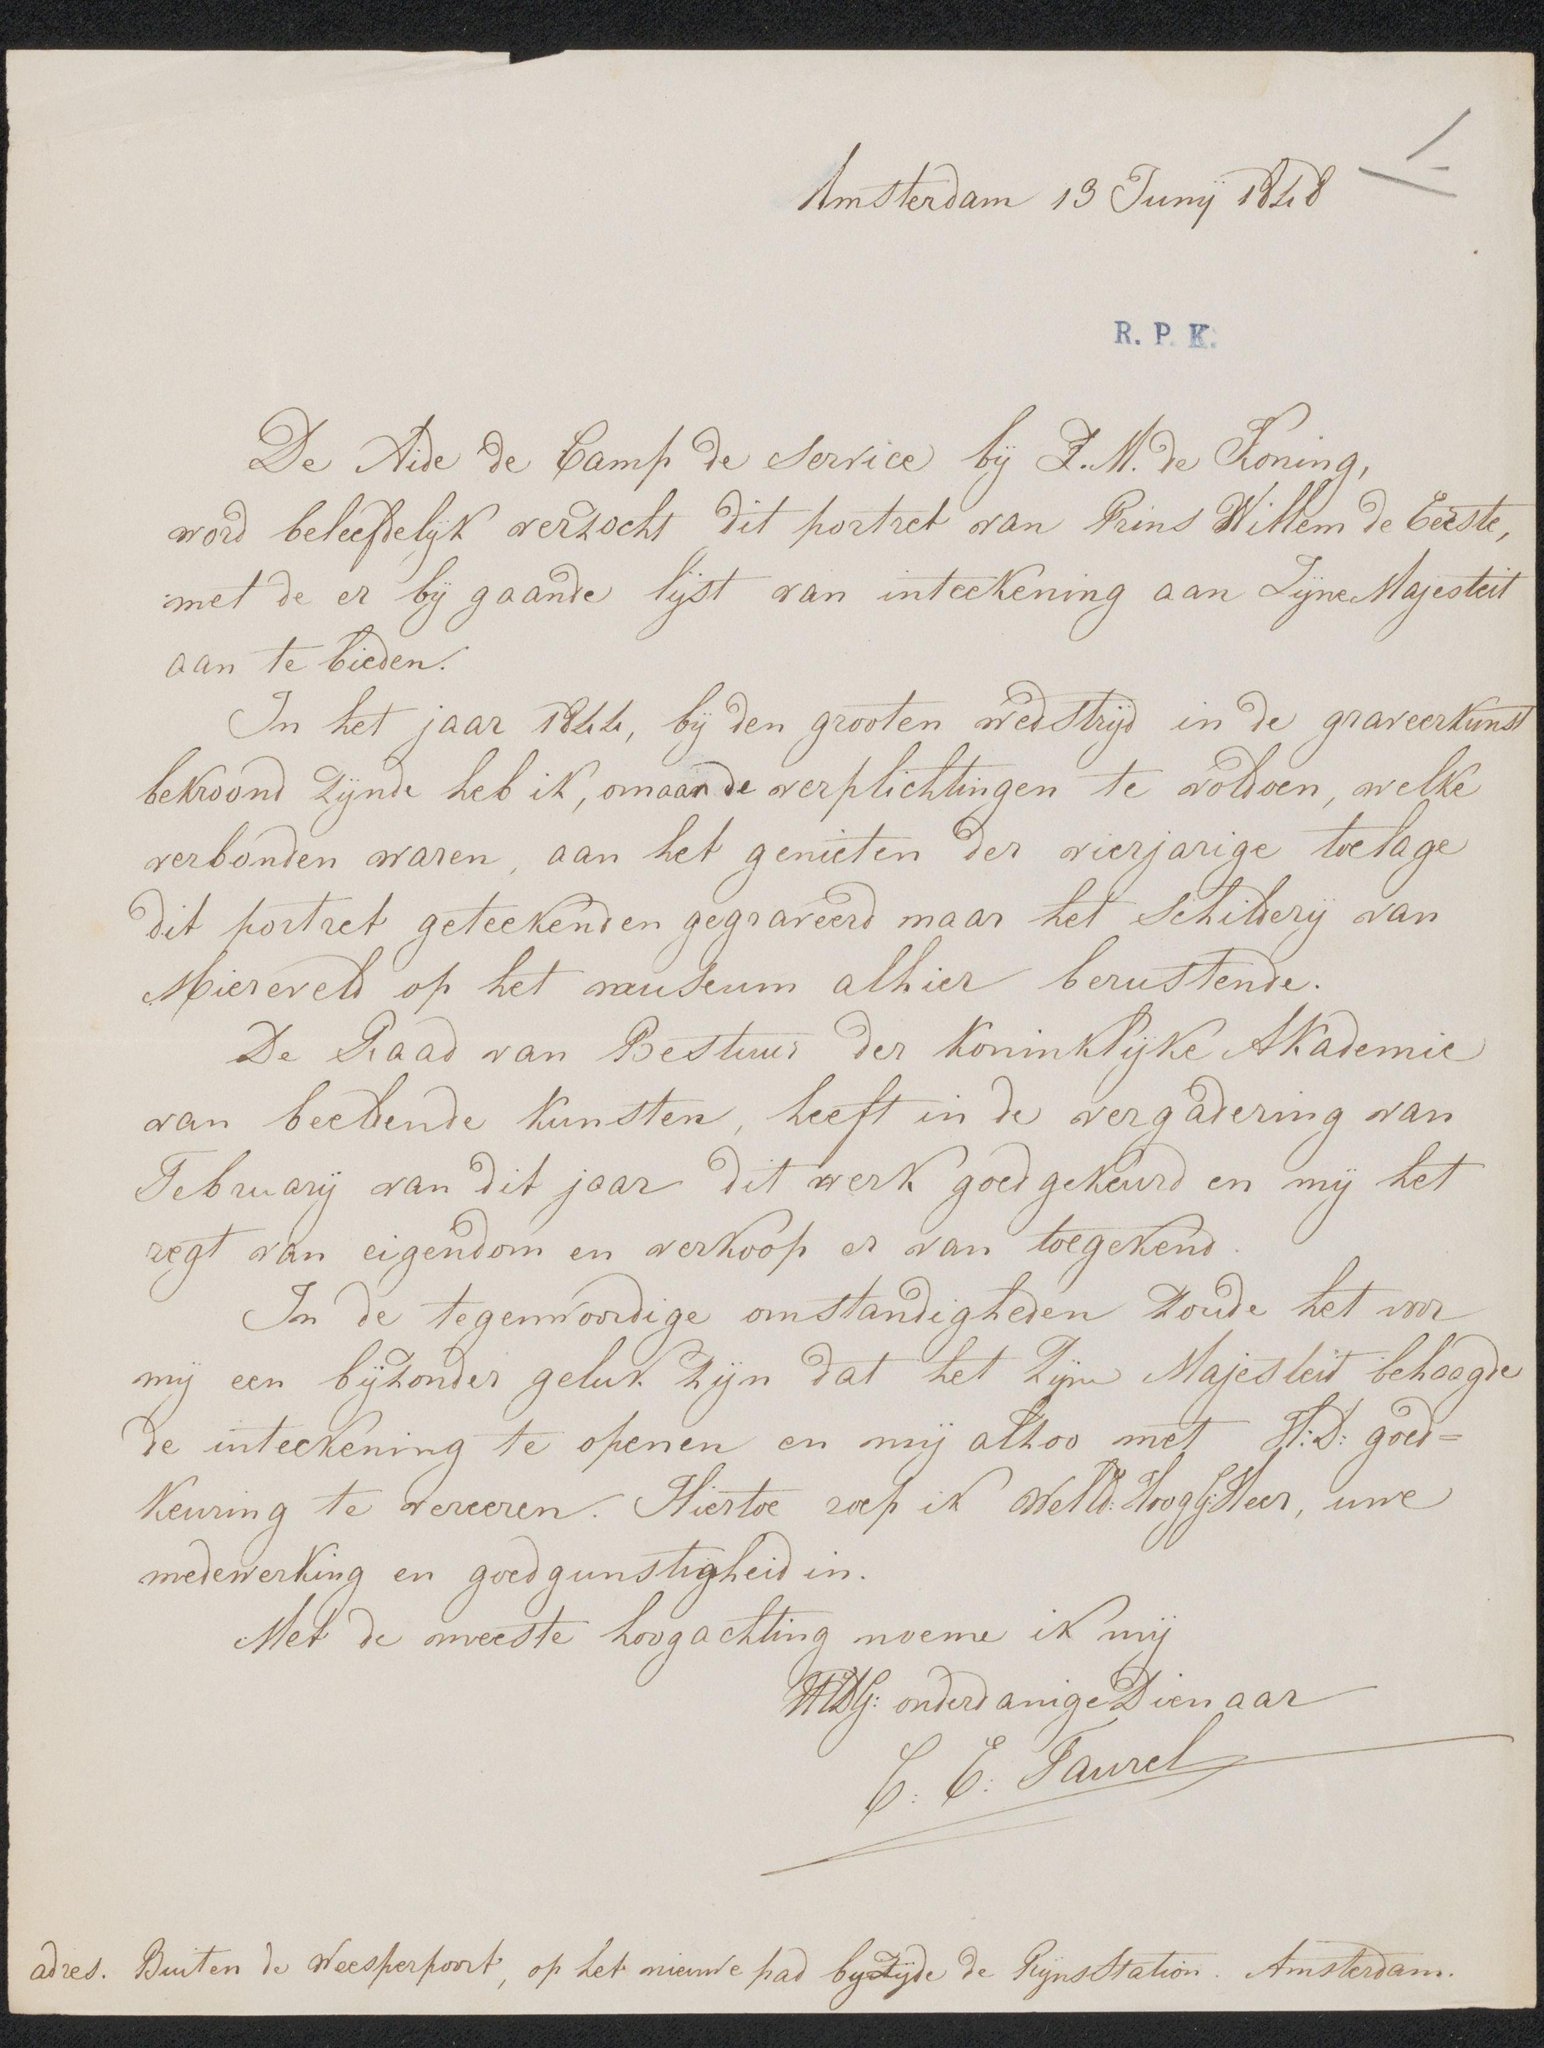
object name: letter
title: Brief aan de adjudant van Willem II (Koning der Nederlanden)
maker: edouard taurel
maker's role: draughtsman, print maker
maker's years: 1824-1892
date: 1848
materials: ink, paper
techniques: pen, writing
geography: amsterdam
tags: delft, painter, draughtsman, michiel jansz van mierevelt, the hague, william ii of the netherlands, william i (prince of orange), rijksmuseum amsterdam, the graphic arts, painting (including book-illumination, miniature-painting), historical persons (portraits and scenes from the life)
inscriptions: collector's mark: Lugt 2233